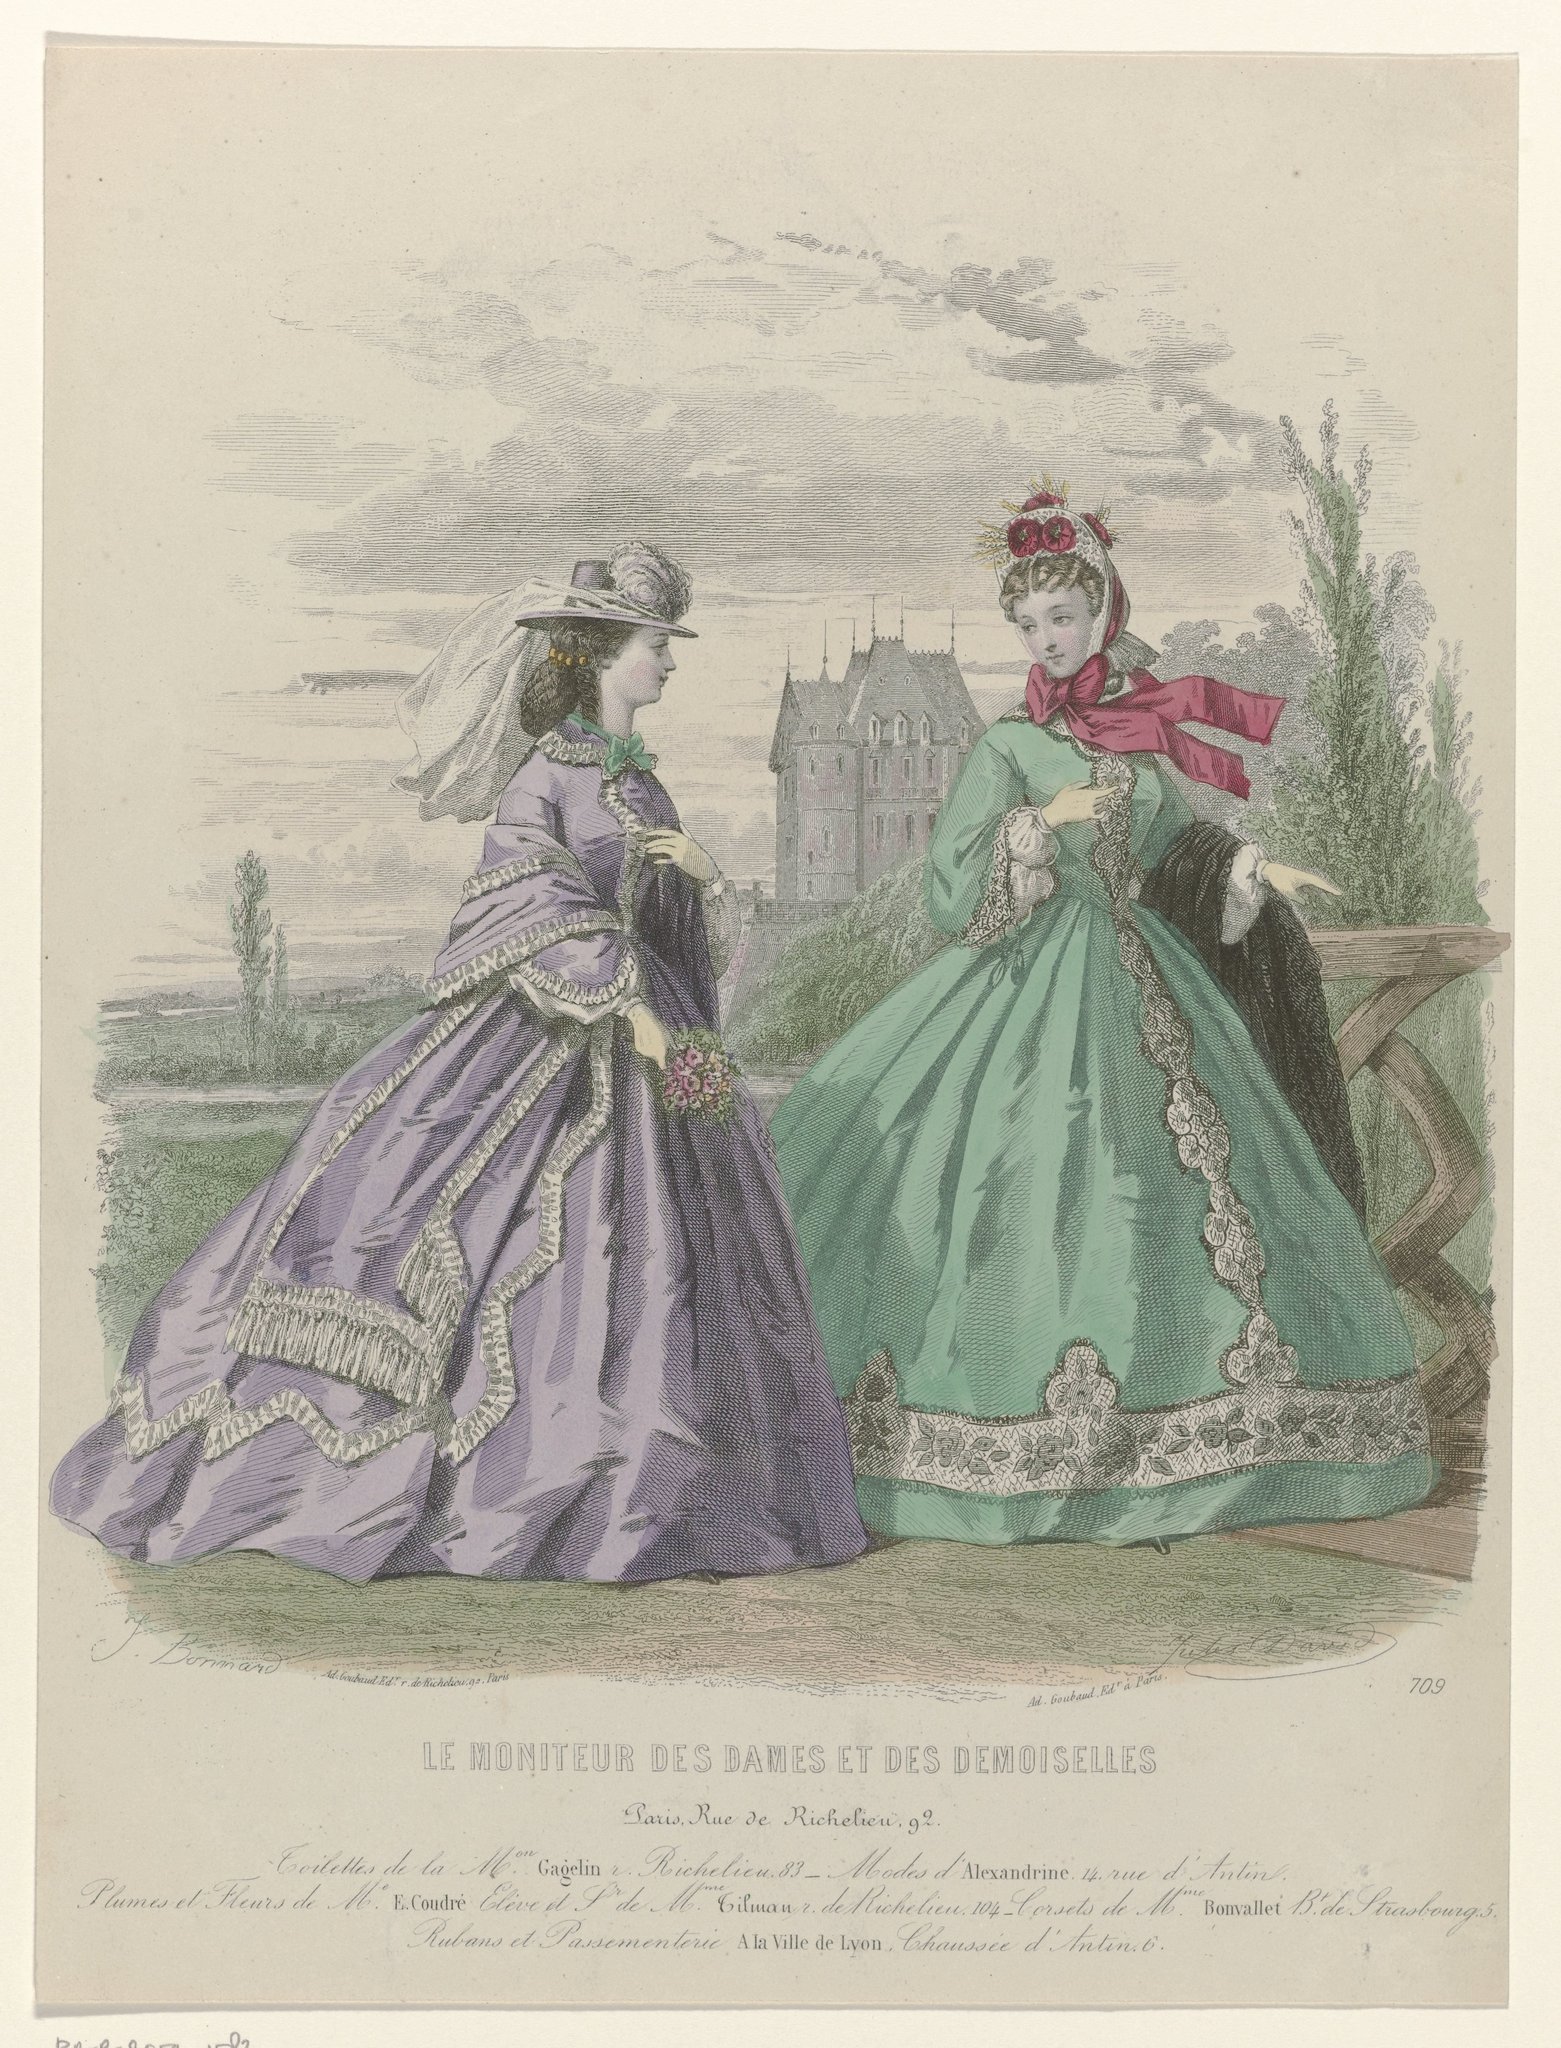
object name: fashion print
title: An Explosion of Fashion Magazines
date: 1863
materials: paper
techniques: engraving, hand coloring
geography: paris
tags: cut flowers; nosegay, bunch of flowers, clothing for the upper part of the body (shawl) (+ women's clothes), veil (+ women's clothes), border, ribbon, braid (+ women's clothes), head-gear (fanchon) (+ women's clothes), fashion plates, head-gear: hat (+ women's clothes), landscape with tower or castle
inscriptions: address: ‘Paris, Rue de Richelieu, 92.’, title: ‘Le Moniteur des Dames et des Demoiselles’, caption: ‘Toilettes de la M.on Gagelin r. Richelieu, 83_ Modes d'Alexandrine, 14 rue d'Antin. Plumes et Fleurs de M.e E.Coudré Eléve et S.r de M.me Tilman r. de Richelieu, 104_ Corsets de M.me Bonvallet B.t de Strasbourg. 5. Rubans et Passementerie A la Ville de Lyon, Chaussée d'Antin, 6.’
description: Starting from the 1850s, fashion magazines became more affordable and acquired a wider readership. The invention of the sewing machine around 1850 made it easier for people to make their own clothes. Ready-made garments were now also on offer, with fashion plates providing vendor addresses, such as the Maison Gagelin in Paris.